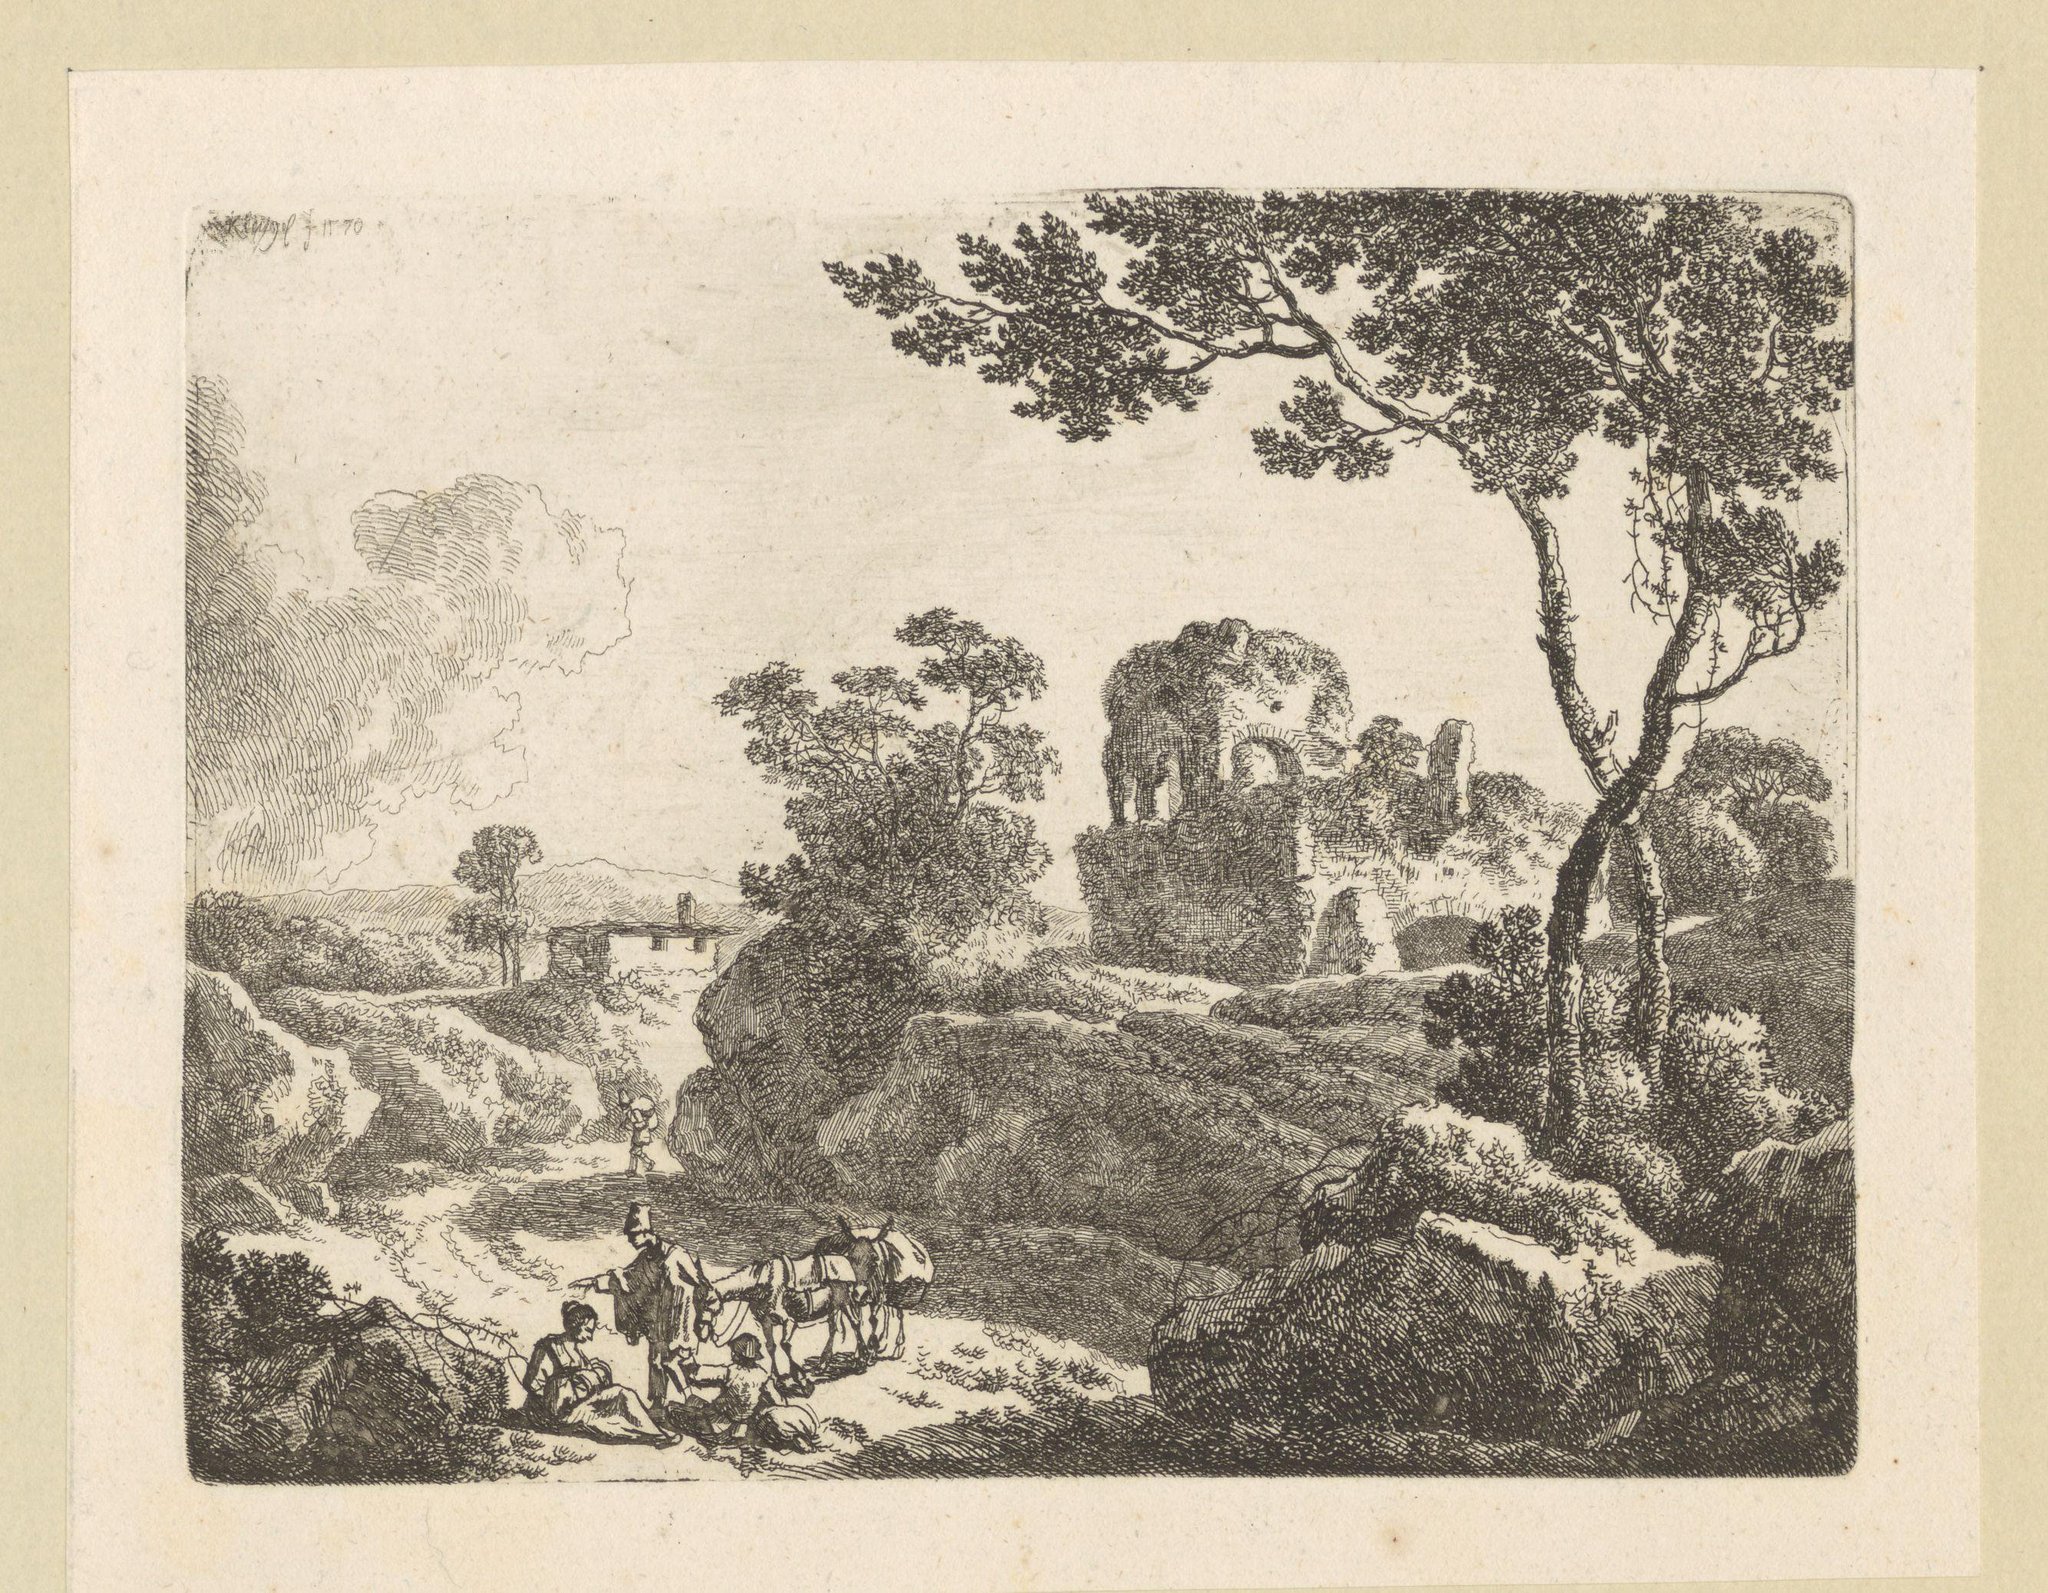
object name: print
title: Landschap met ruïne en rustende reizigers bij hun ezels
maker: johann christian klengel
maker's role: print maker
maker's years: 1751-1824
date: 1770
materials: paper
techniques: etching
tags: ass, donkey, (traveller) resting in the open air, landscape with ruins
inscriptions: collector's mark: Lugt 240